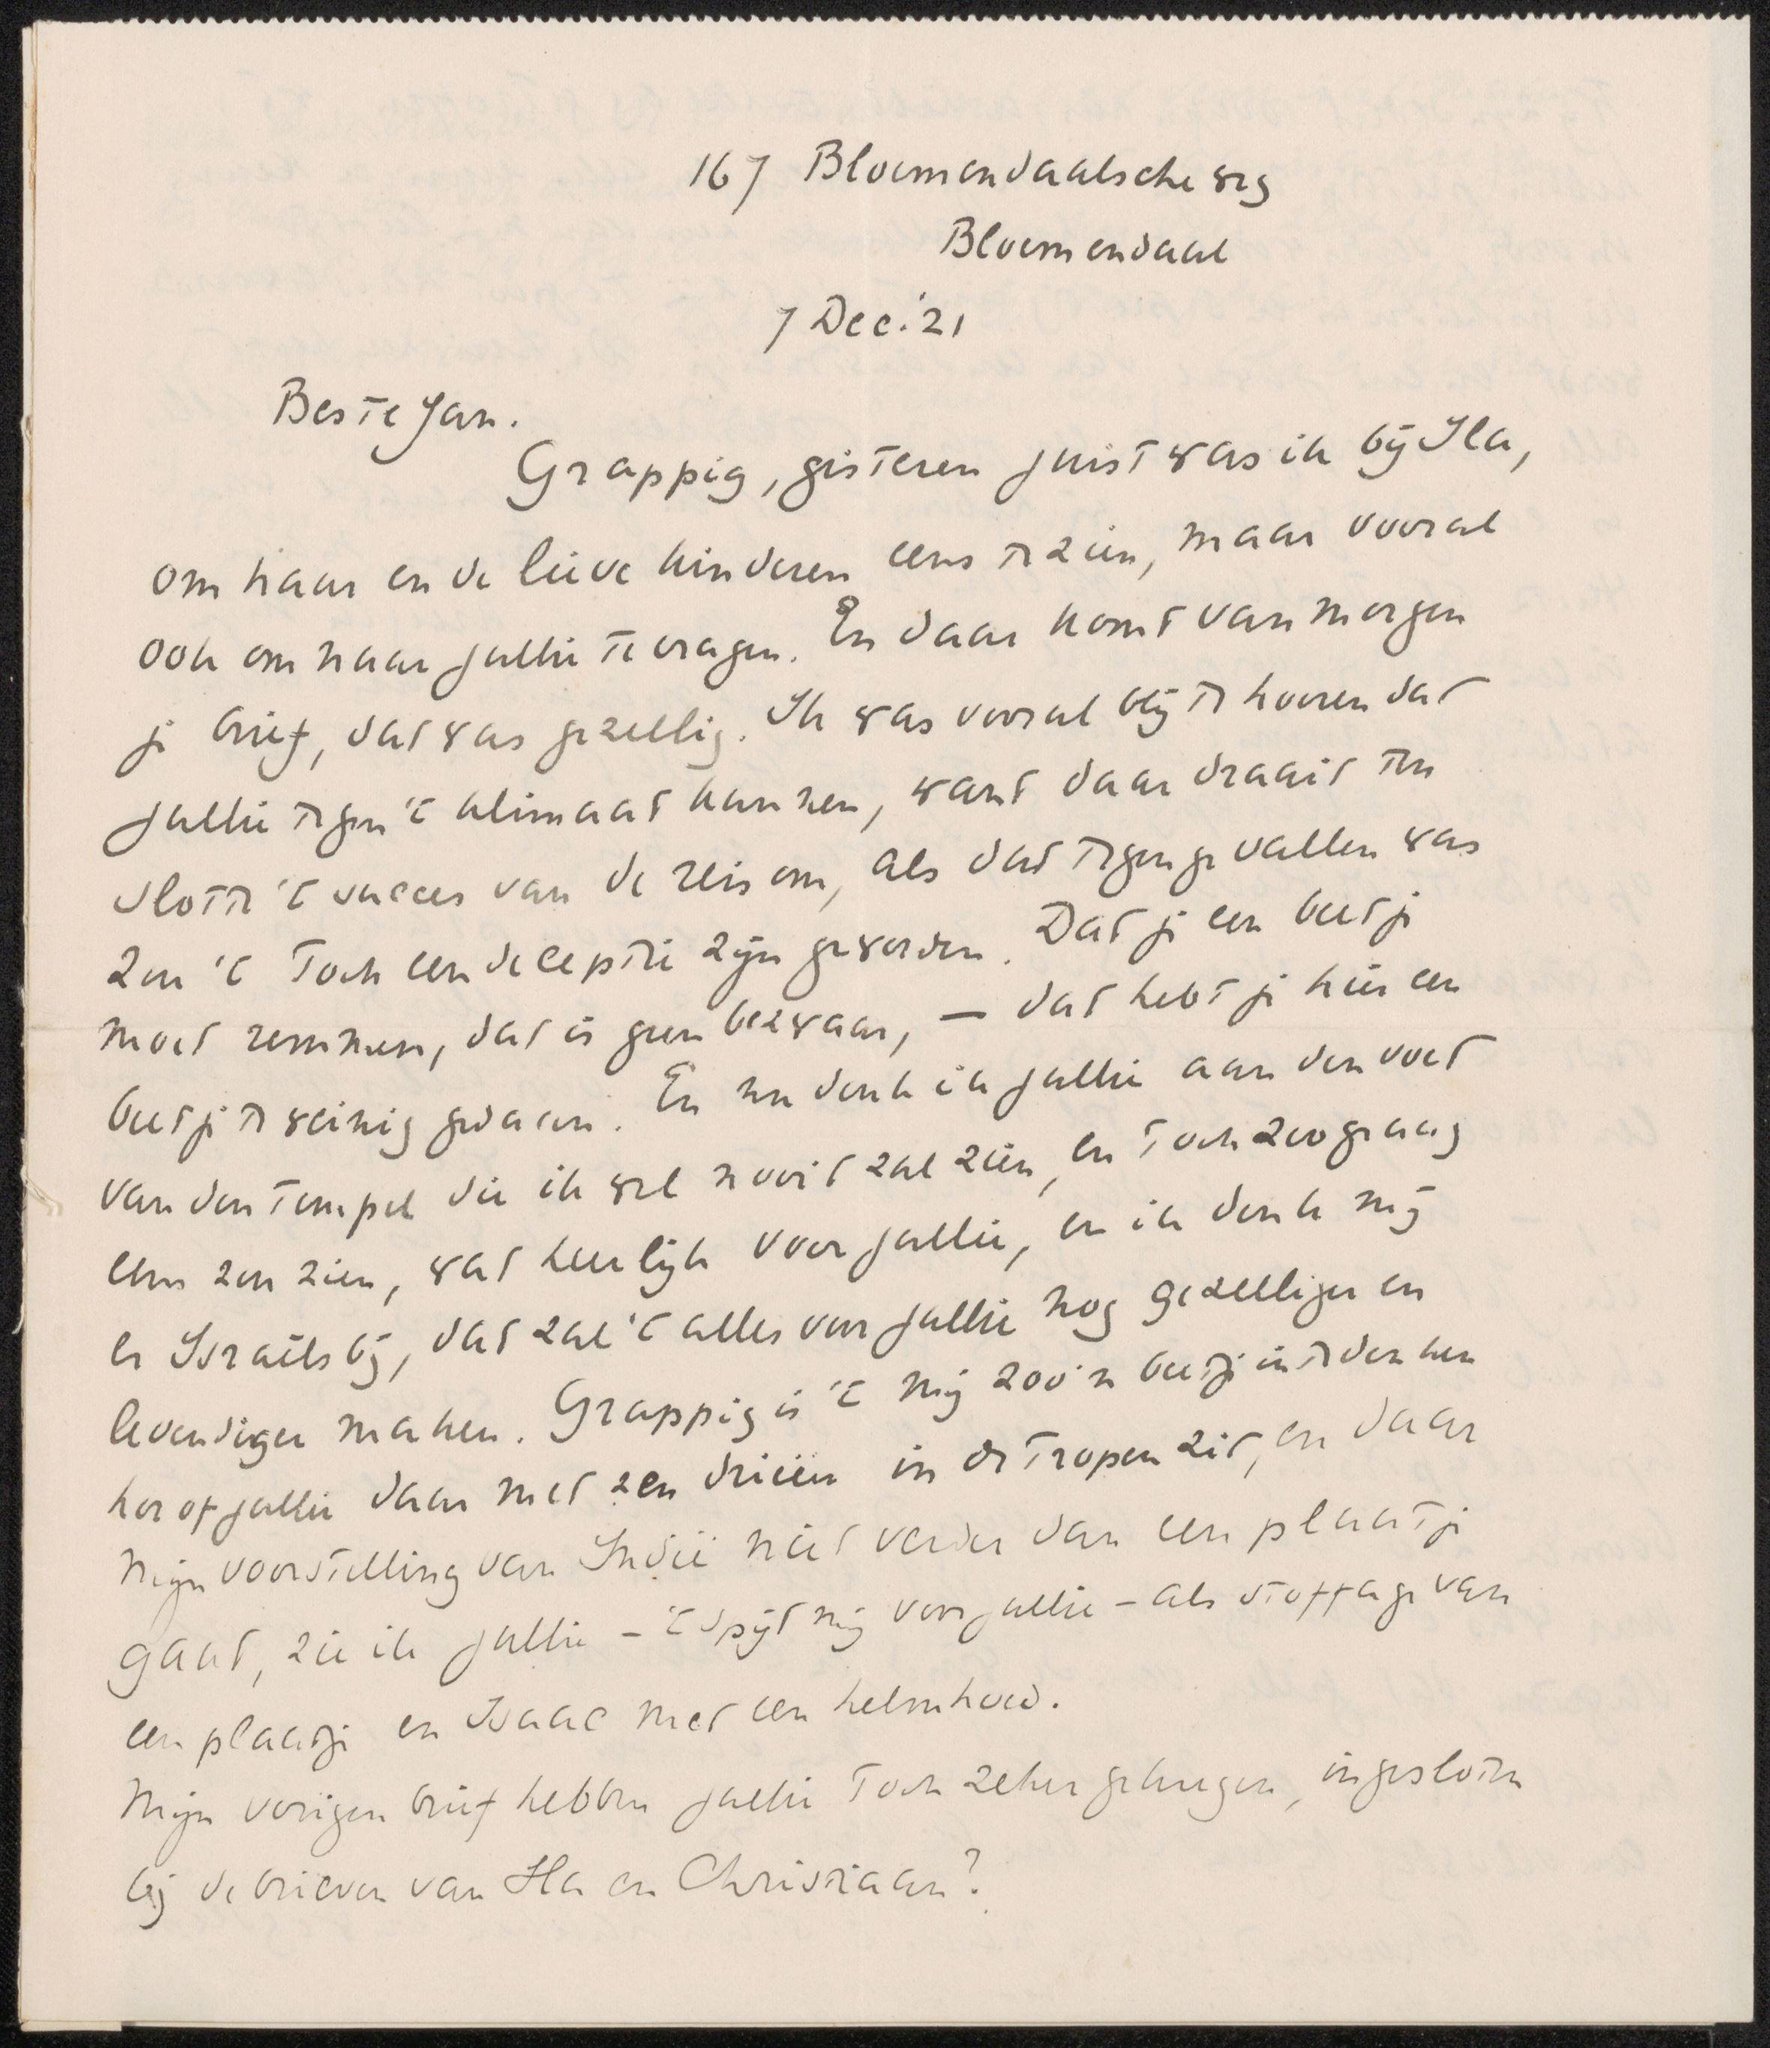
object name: letter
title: Brief aan Jan Veth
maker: richard nicolaüs roland holst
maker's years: 1868-1938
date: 1921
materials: ink, paper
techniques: pen, writing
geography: bloemendaal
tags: dordrecht, designer, jan veth, den bosch, amsterdam, painter, print maker, draughtsman, antoon derkinderen, isaac israels, travelling; tourism, workshop, studio of the artist (in general), dutch east indies, the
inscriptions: collector's mark: ‘RPK’